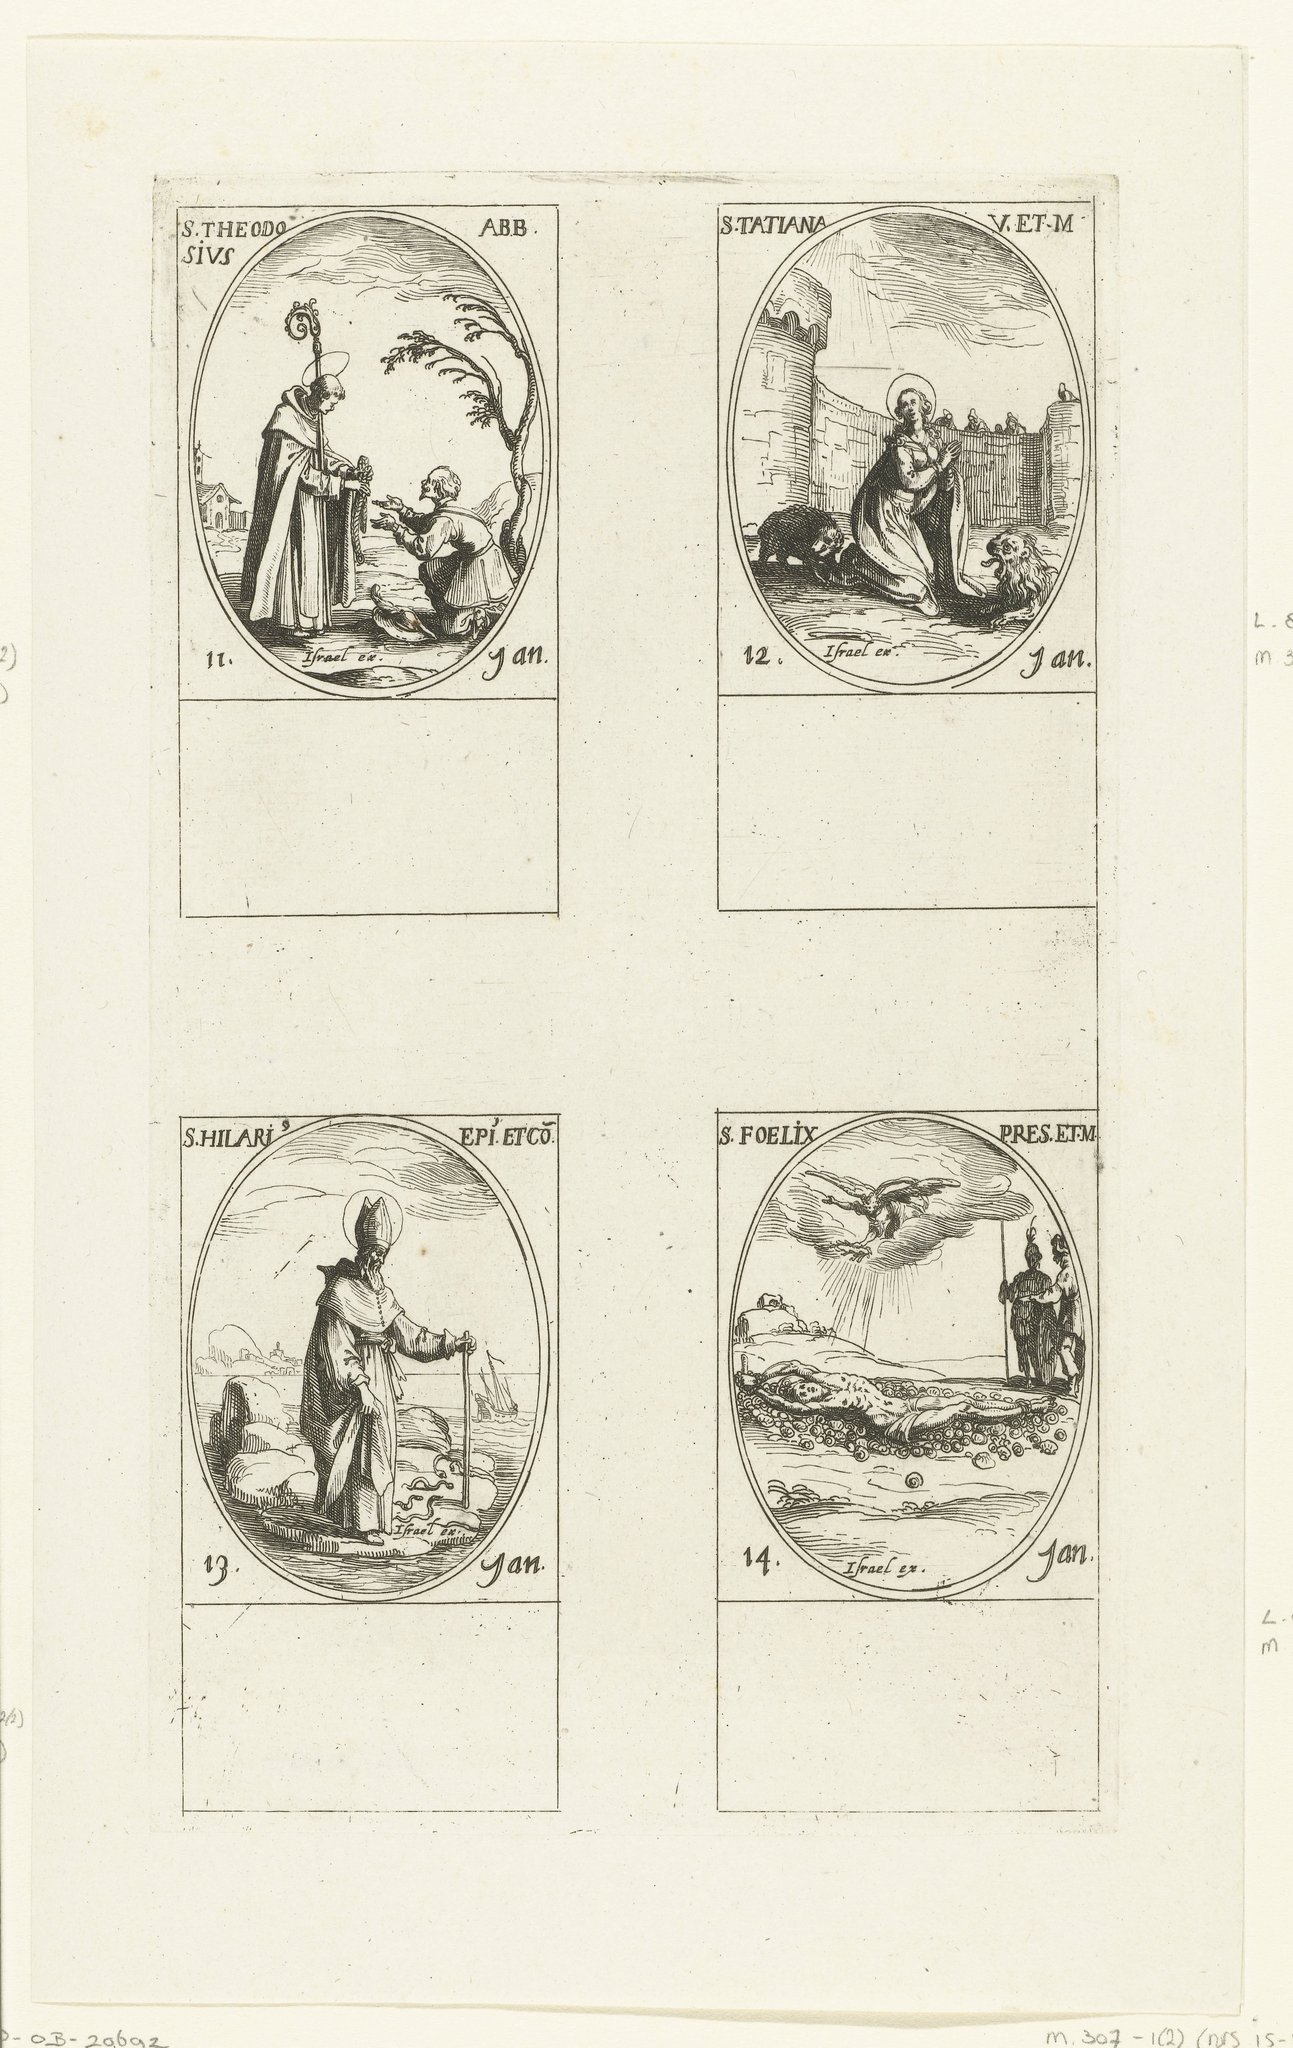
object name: print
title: Heilige Theodosius, Heilige Tatjana, Heilige Hilarius van Poitiers, Heilige Felix (11-14 januari)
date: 1632-1636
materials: paper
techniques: etching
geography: nancy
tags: male saints (with name), hilary (hilarius), bishop of poitiers; possible attributes: serpent(s), female saints (with name)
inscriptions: collector's mark: Lugt 240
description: Blad met vier ovale voorstellingen, elk met opschrift en datum in het Latijn: linksboven de Heilige Theodosius die een koord of riem aan een knielende man geeft, rechtsboven de Heilige Tatjana bij een stadsmuur knielend tussen een varken en een leeuw, linksonder de Heilige Hilarius van Poitiers op een rots in het water, rechtsonder de Heilige Felix die gebonden aan handen en voeten op stenen (?) ligt. Deze prent is onderdeel van een serie prenten met voorstellingen van de heiligen en de christelijke feestdagen van het jaar. Er zijn steeds vier scènes van één plaat op één blad gedrukt. Inclusief bijbehorend titelblad en frontispice gaat het in totaal om 124 platen (490 voorstellingen). De drie platen met de laatste 12 scènes (de veranderlijke christelijke feestdagen) zijn in de derde staat versneden tot 12 kleine plaatjes, en met een apart titelblad uitgegeven.